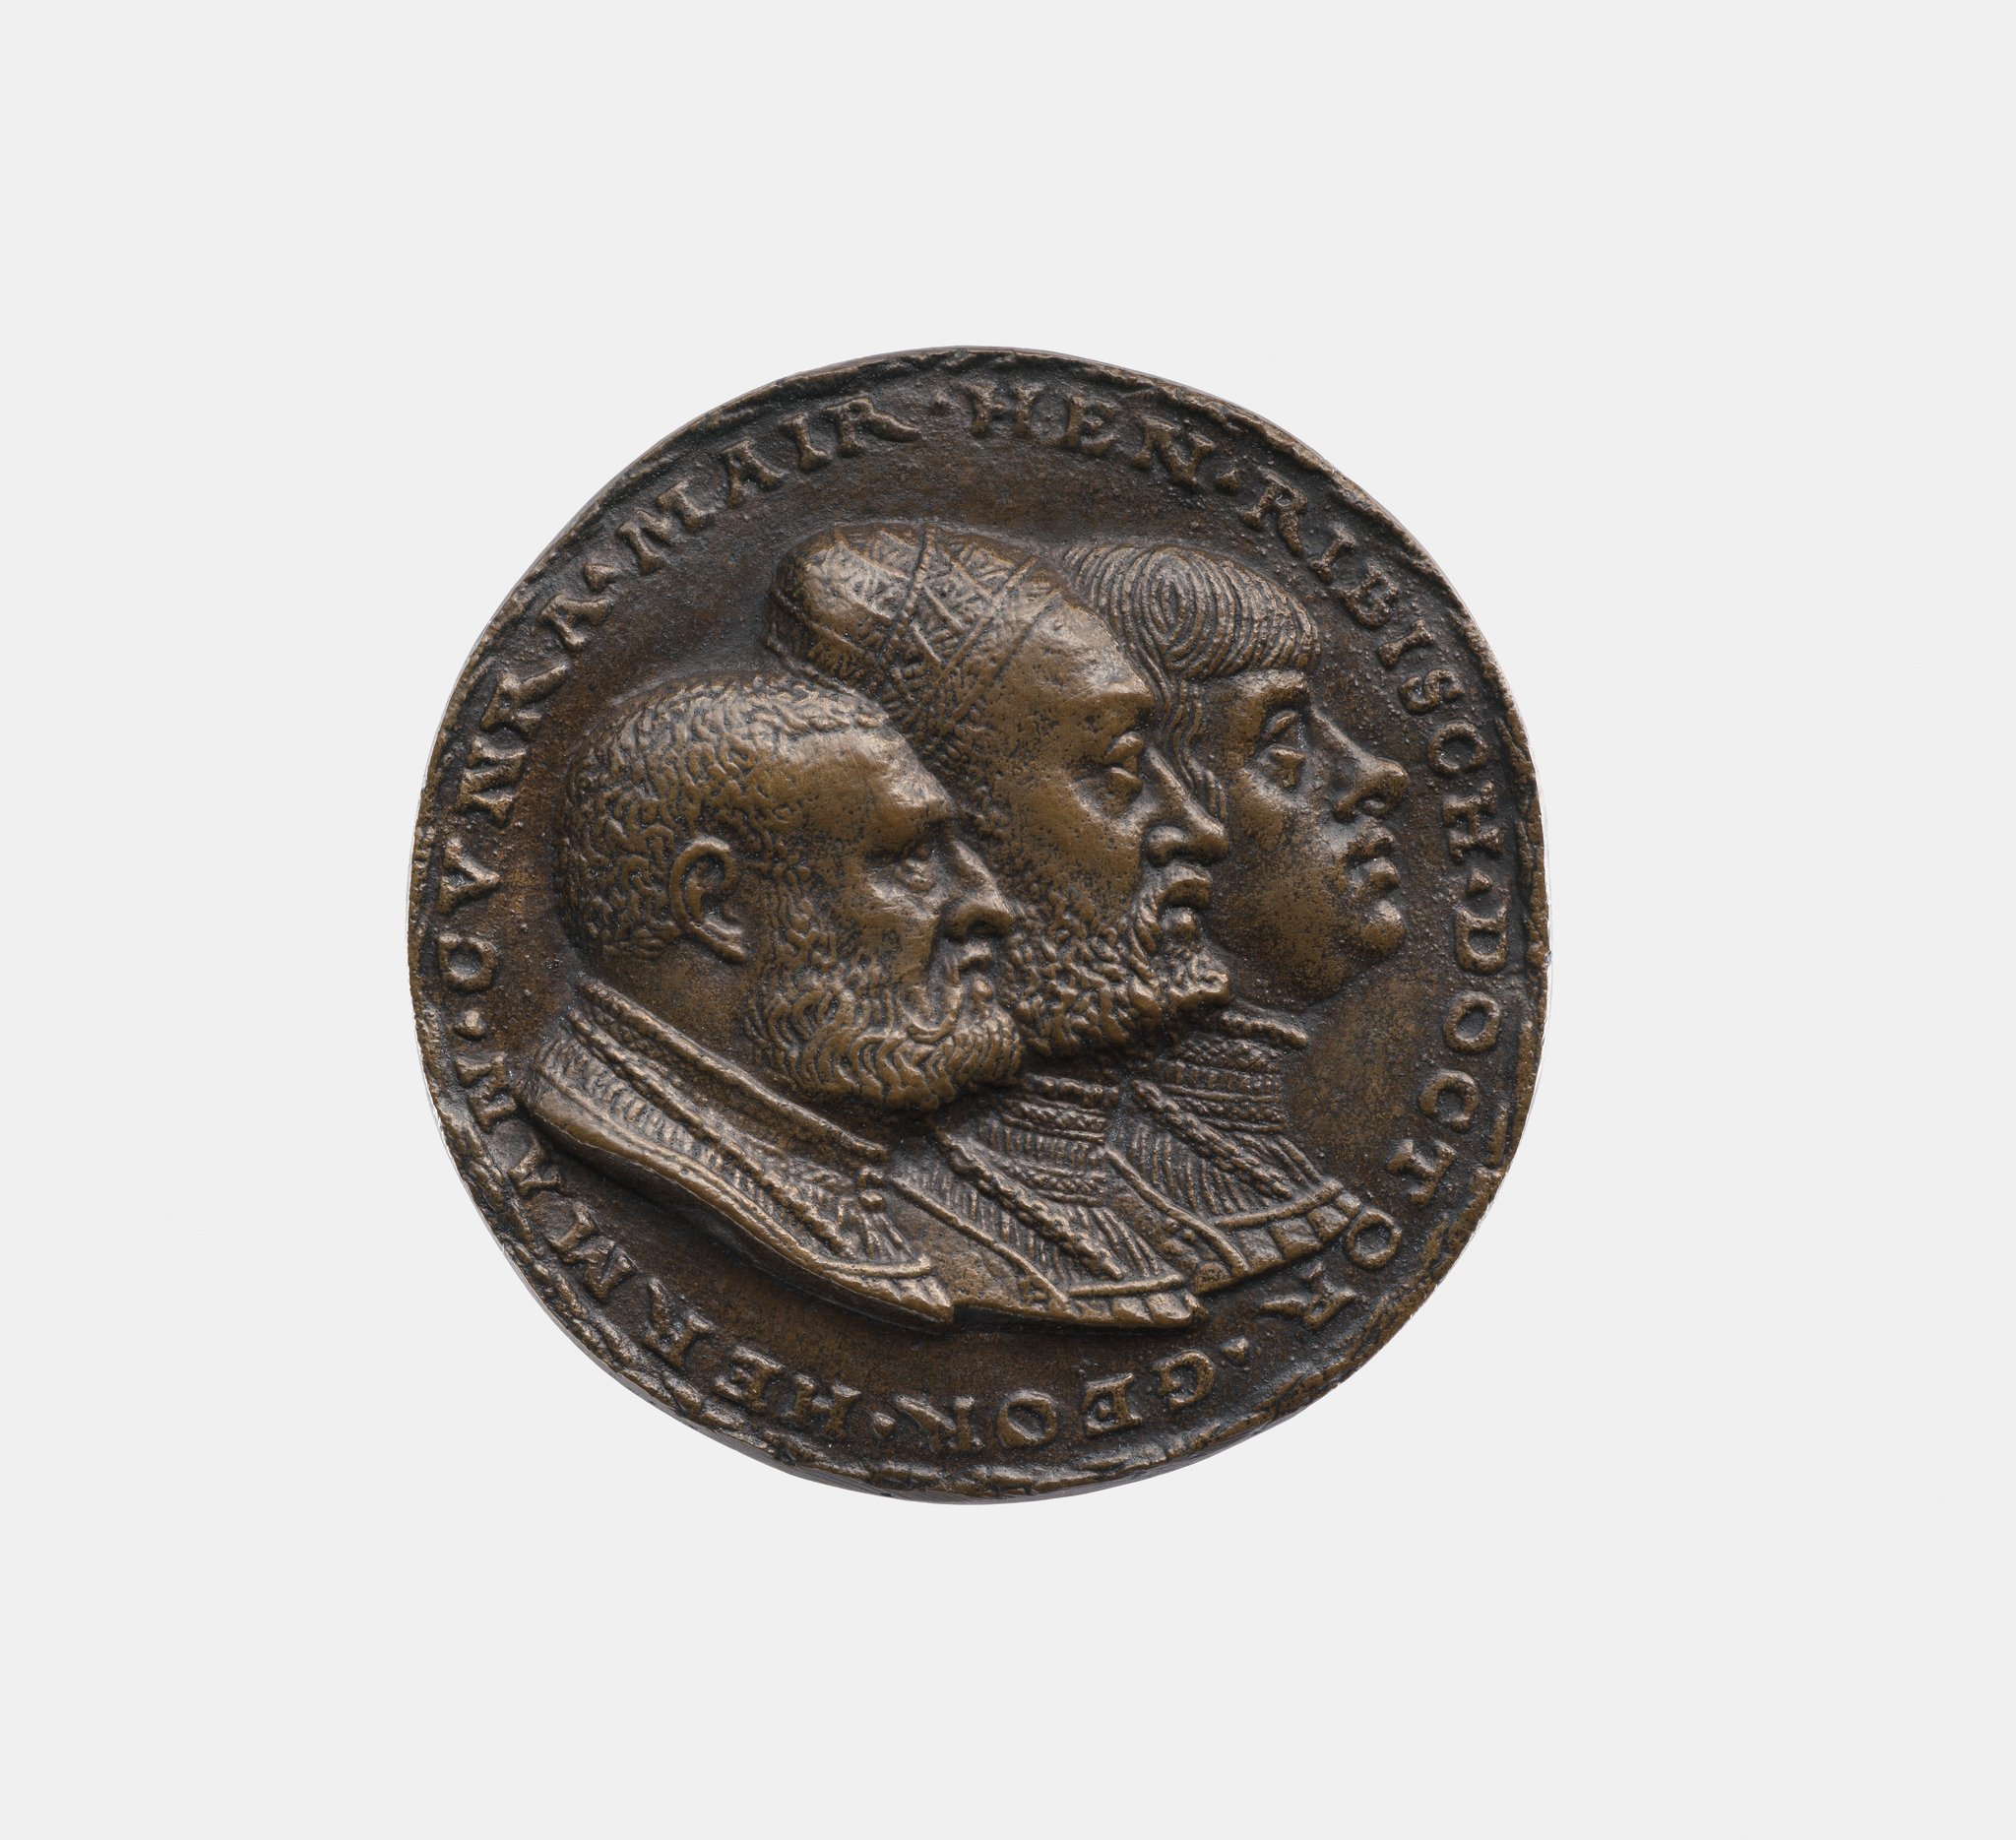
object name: medal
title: Heinrich Ribisch (1485–1544), Georg Hermann (1491–1552), and Konrad Maier (1493–1565)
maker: matthes gebel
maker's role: artist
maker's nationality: german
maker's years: 1523-1574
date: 1531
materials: bronze